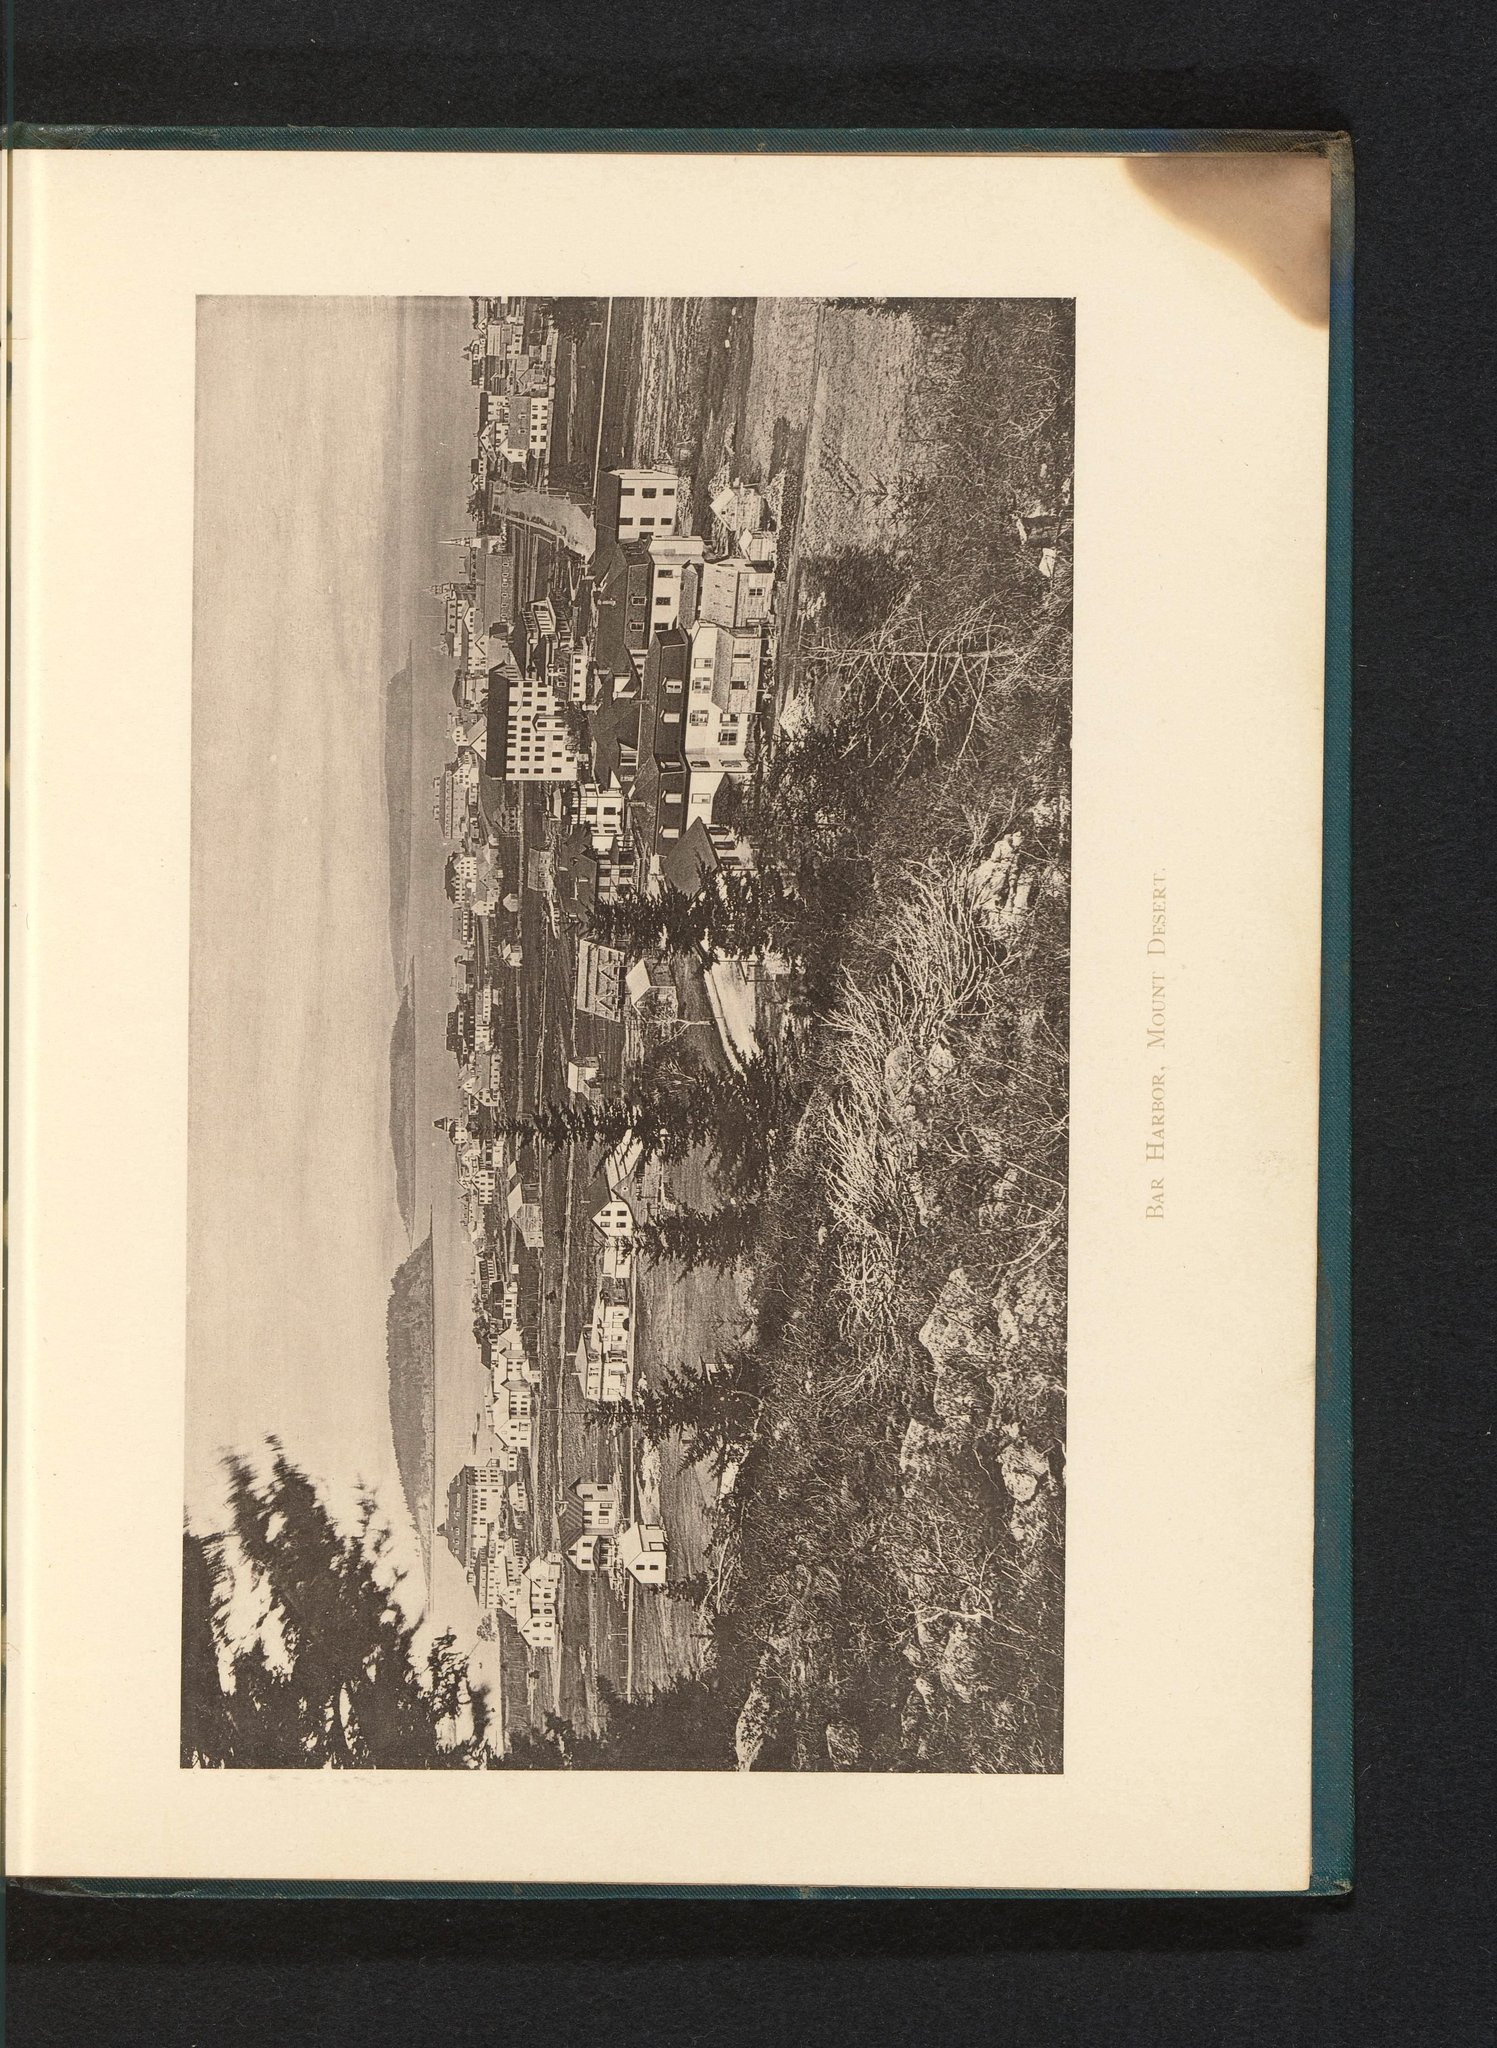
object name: photomechanical print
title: Gezicht op Bar Harbor op Mount Desert Island in Maine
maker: Anonymous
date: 1875-1880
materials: paper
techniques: photograph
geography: bar harbor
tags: city-view, and landscape with man-made constructions